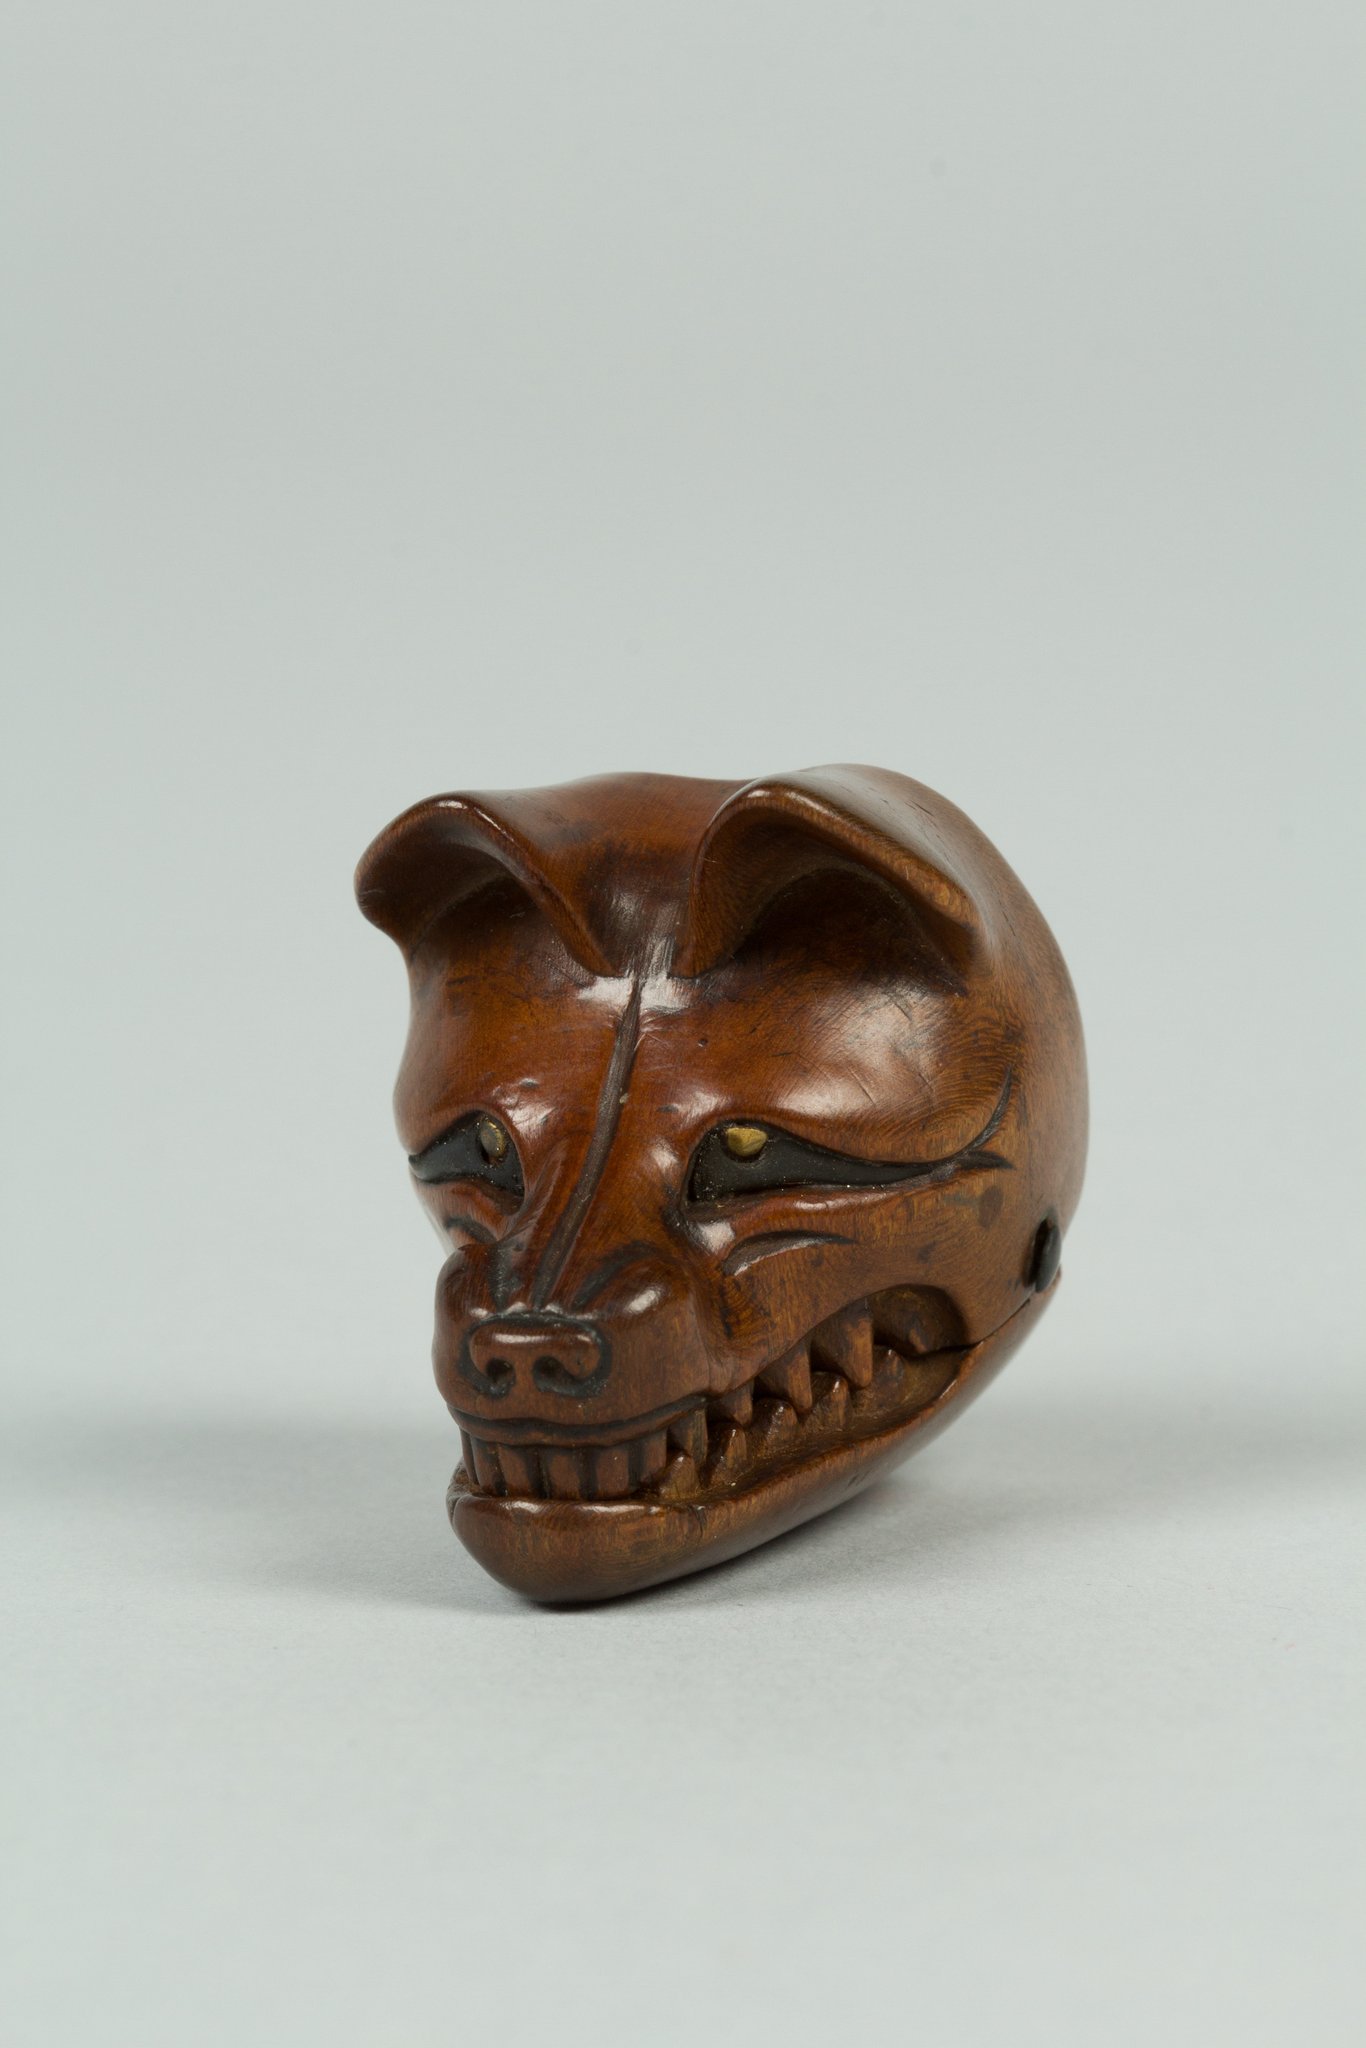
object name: netsuke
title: Netsuke of Fox Mask with Movable Jaw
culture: japanese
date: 1801-1900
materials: wood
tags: masks,foxes